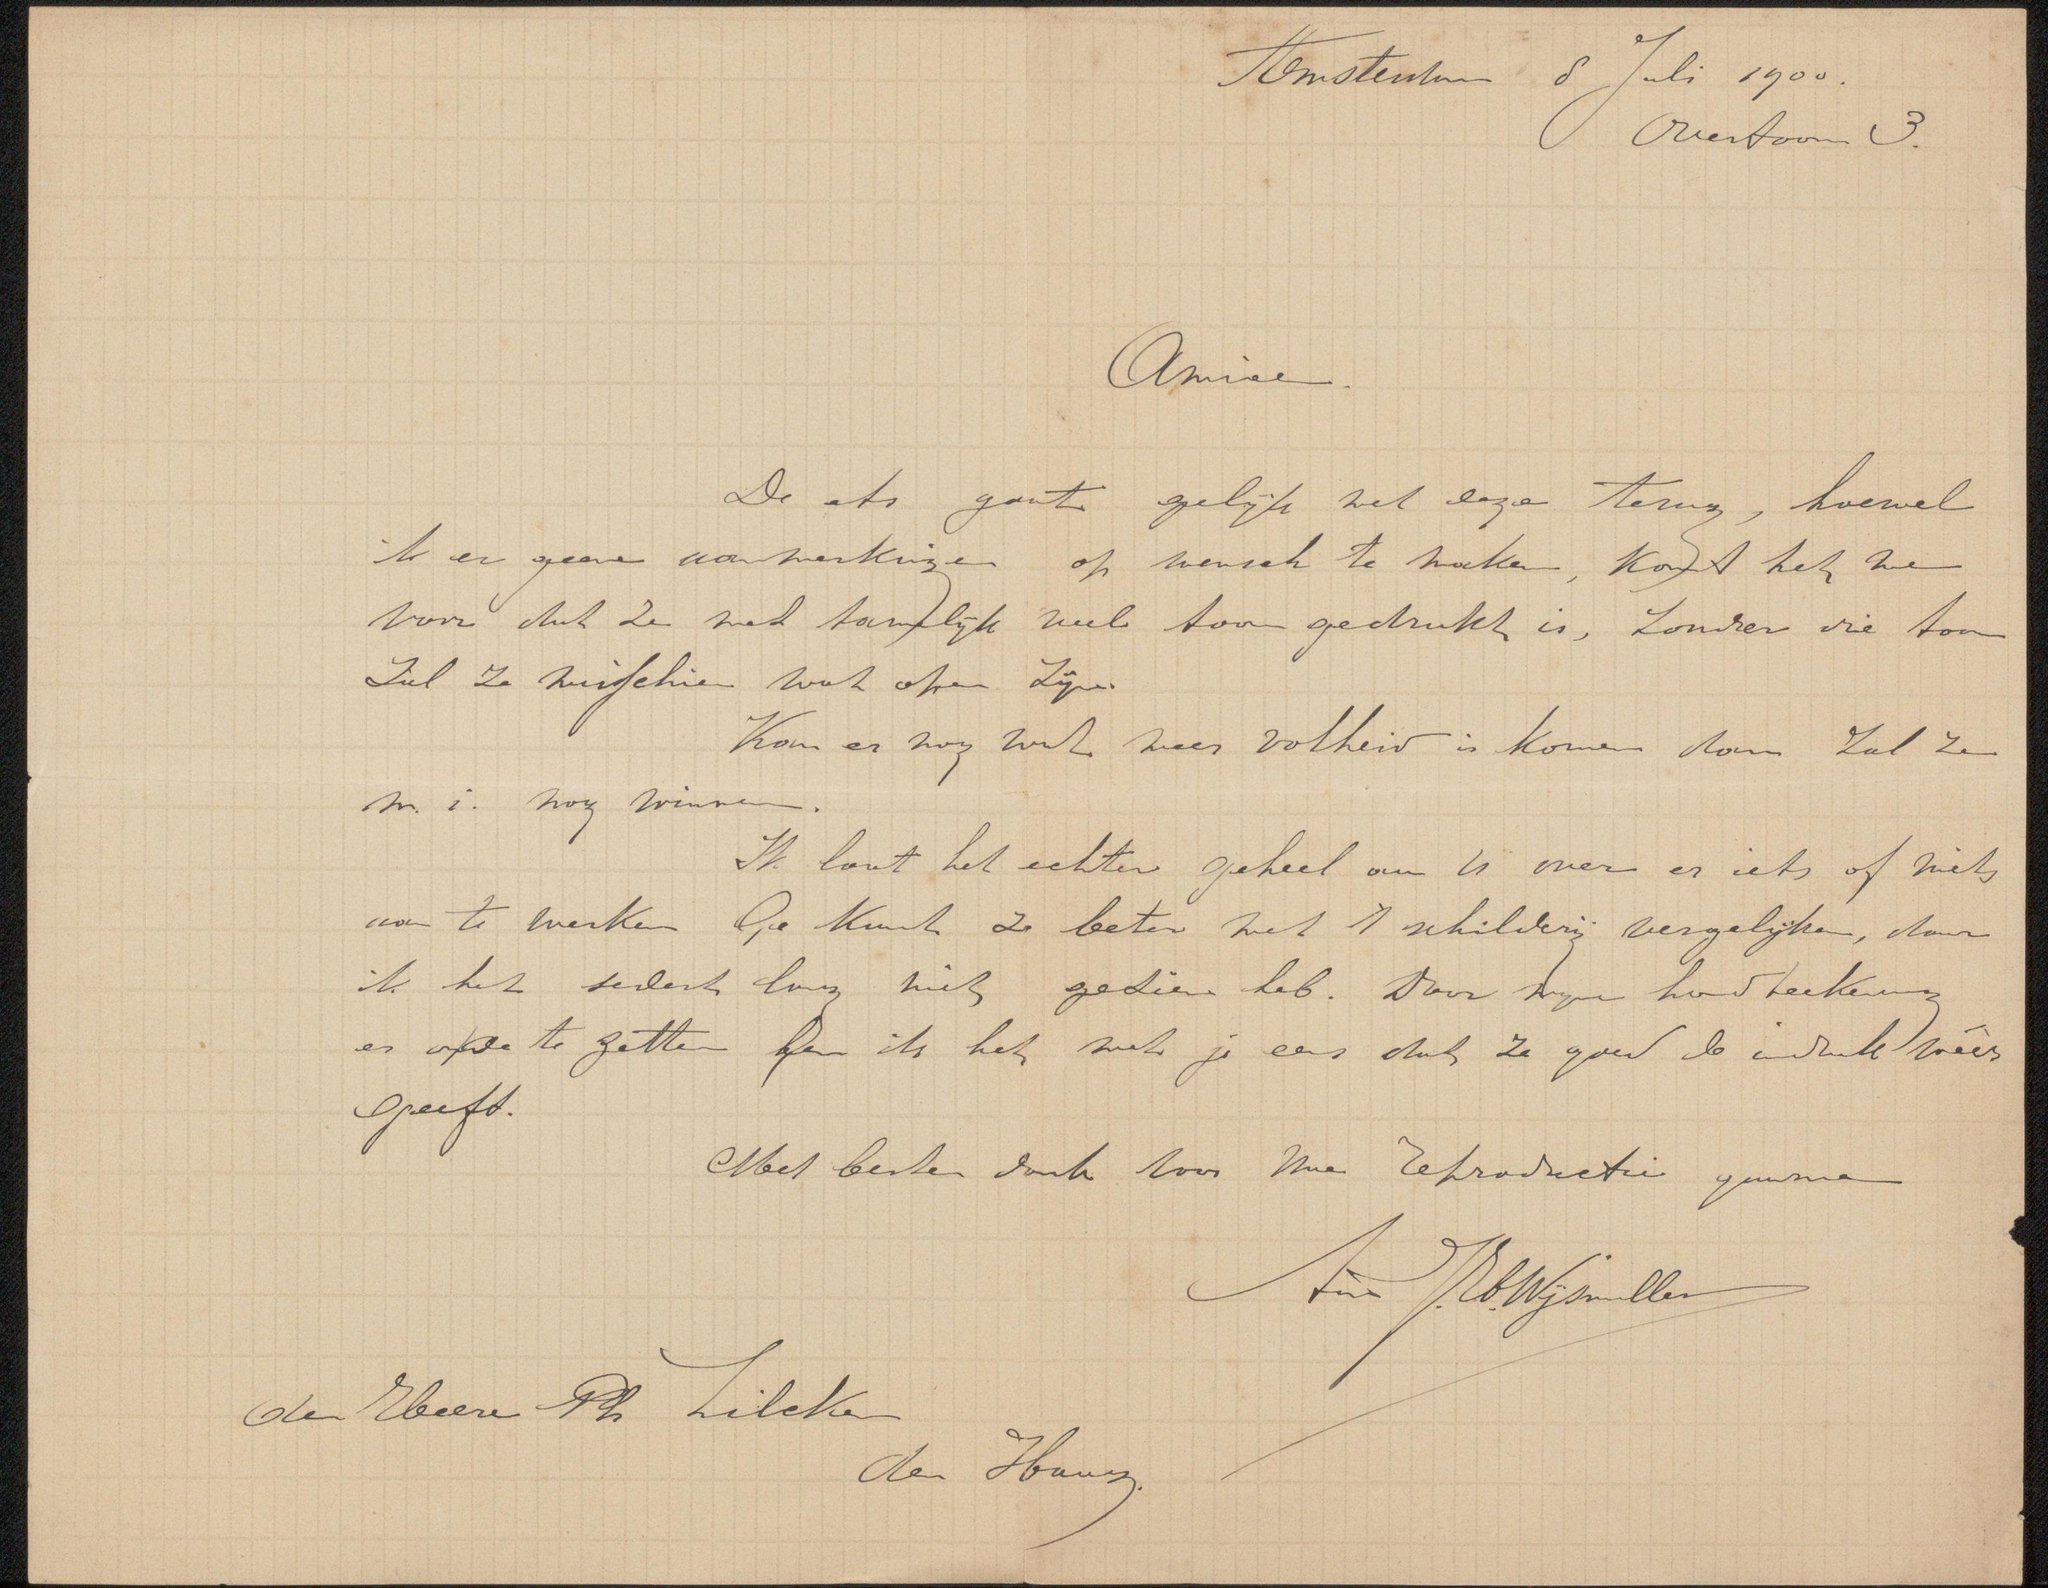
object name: letter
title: Brief aan Philip Zilcken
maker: jan hillebrand wijsmuller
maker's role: painter, print maker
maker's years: 1855-1925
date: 1900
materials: ink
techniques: pen, writing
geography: amsterdam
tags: the hague, painter, draughtsman, philip zilcken, the graphic arts, painting (including book-illumination, miniature-painting)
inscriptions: collector's mark: ‘RPK’